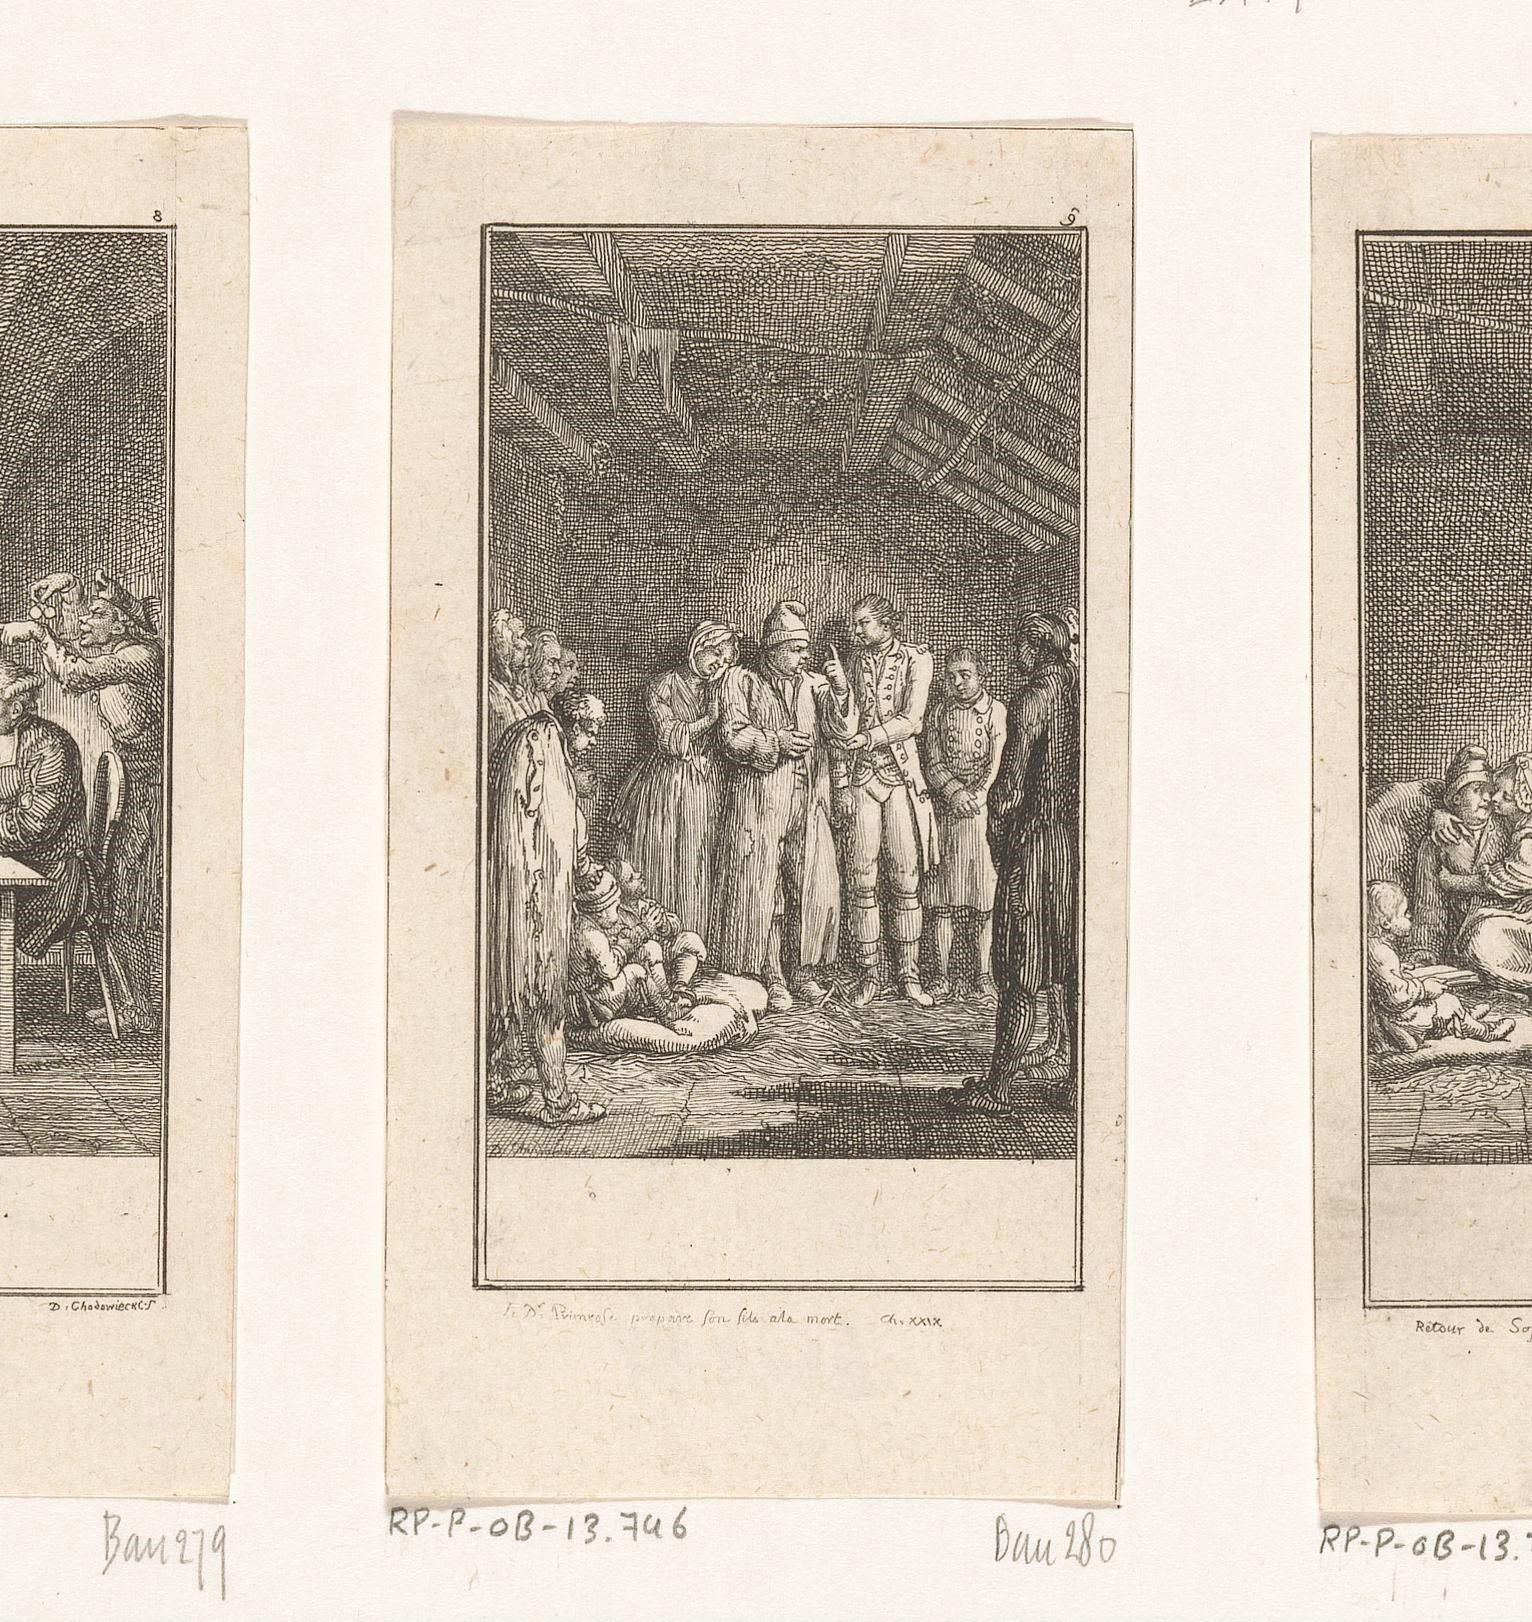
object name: print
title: Le dr Primrose prepare son fils ala mort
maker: daniel nikolaus chodowiecki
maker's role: draughtsman, print maker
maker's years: 1726-1801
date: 1776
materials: paper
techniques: etching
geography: berlin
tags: london, oliver goldsmith, prison, jail, (goldsmith, the vicar of wakefield) specific works of literature (with author, title)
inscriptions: collector's mark: Lugt 2228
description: Negende scène uit een serie van twaalf scènes die 'The Vicar of Wakefield' door Oliver Goldsmith illustreren. De scènes werden op een plaat geëtst. Een latere staat van deze serie is gebruikt in: 'Almanac Généalogique pour l'an 1777 etc. À Berlin'.